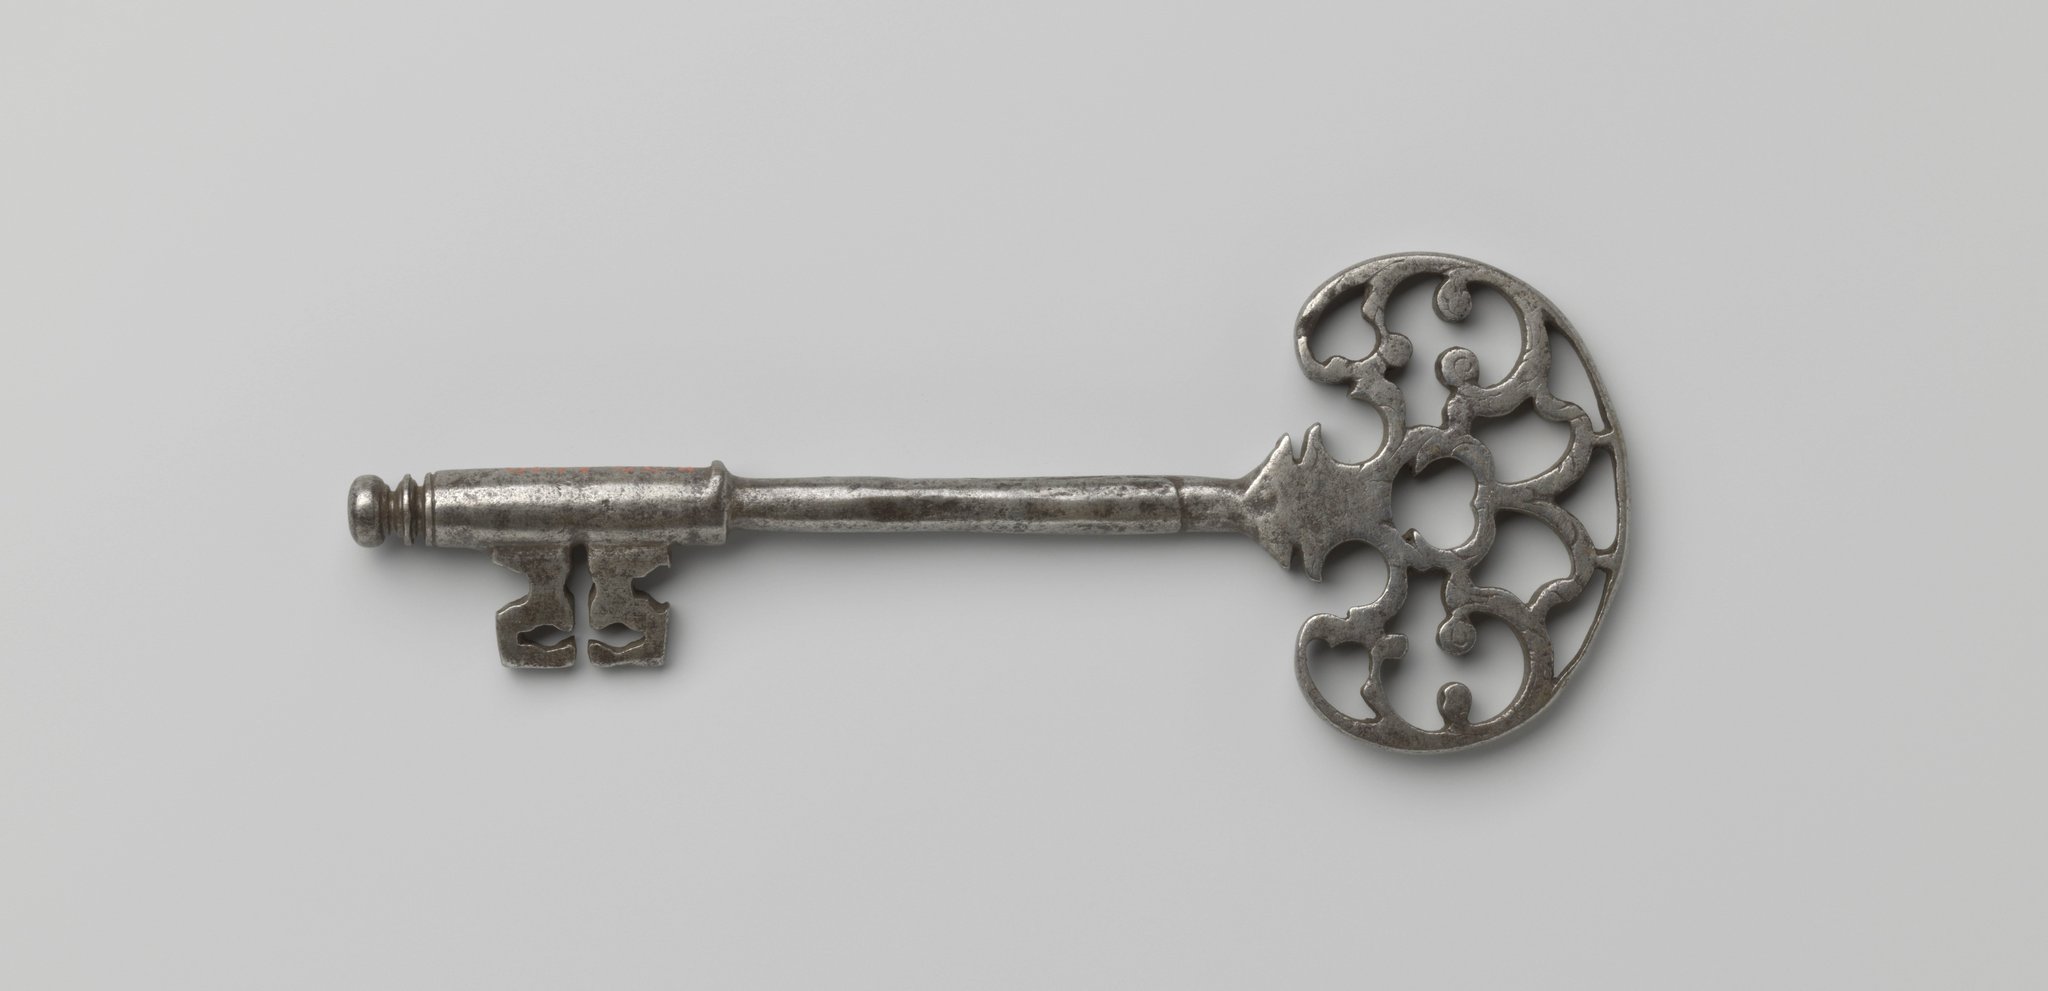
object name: key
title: Sleutel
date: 1700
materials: iron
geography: france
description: Sleutel met waaiervormige greep bestaande uit bladvoluten. De schacht verdikt zich bij de baard en eindigt in een profilering.